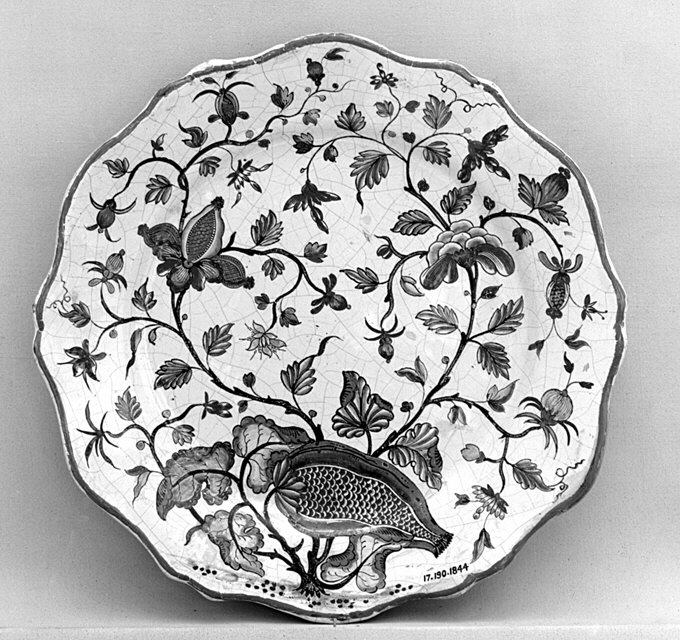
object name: plate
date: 1710-1720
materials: faience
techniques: glazing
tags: flowers